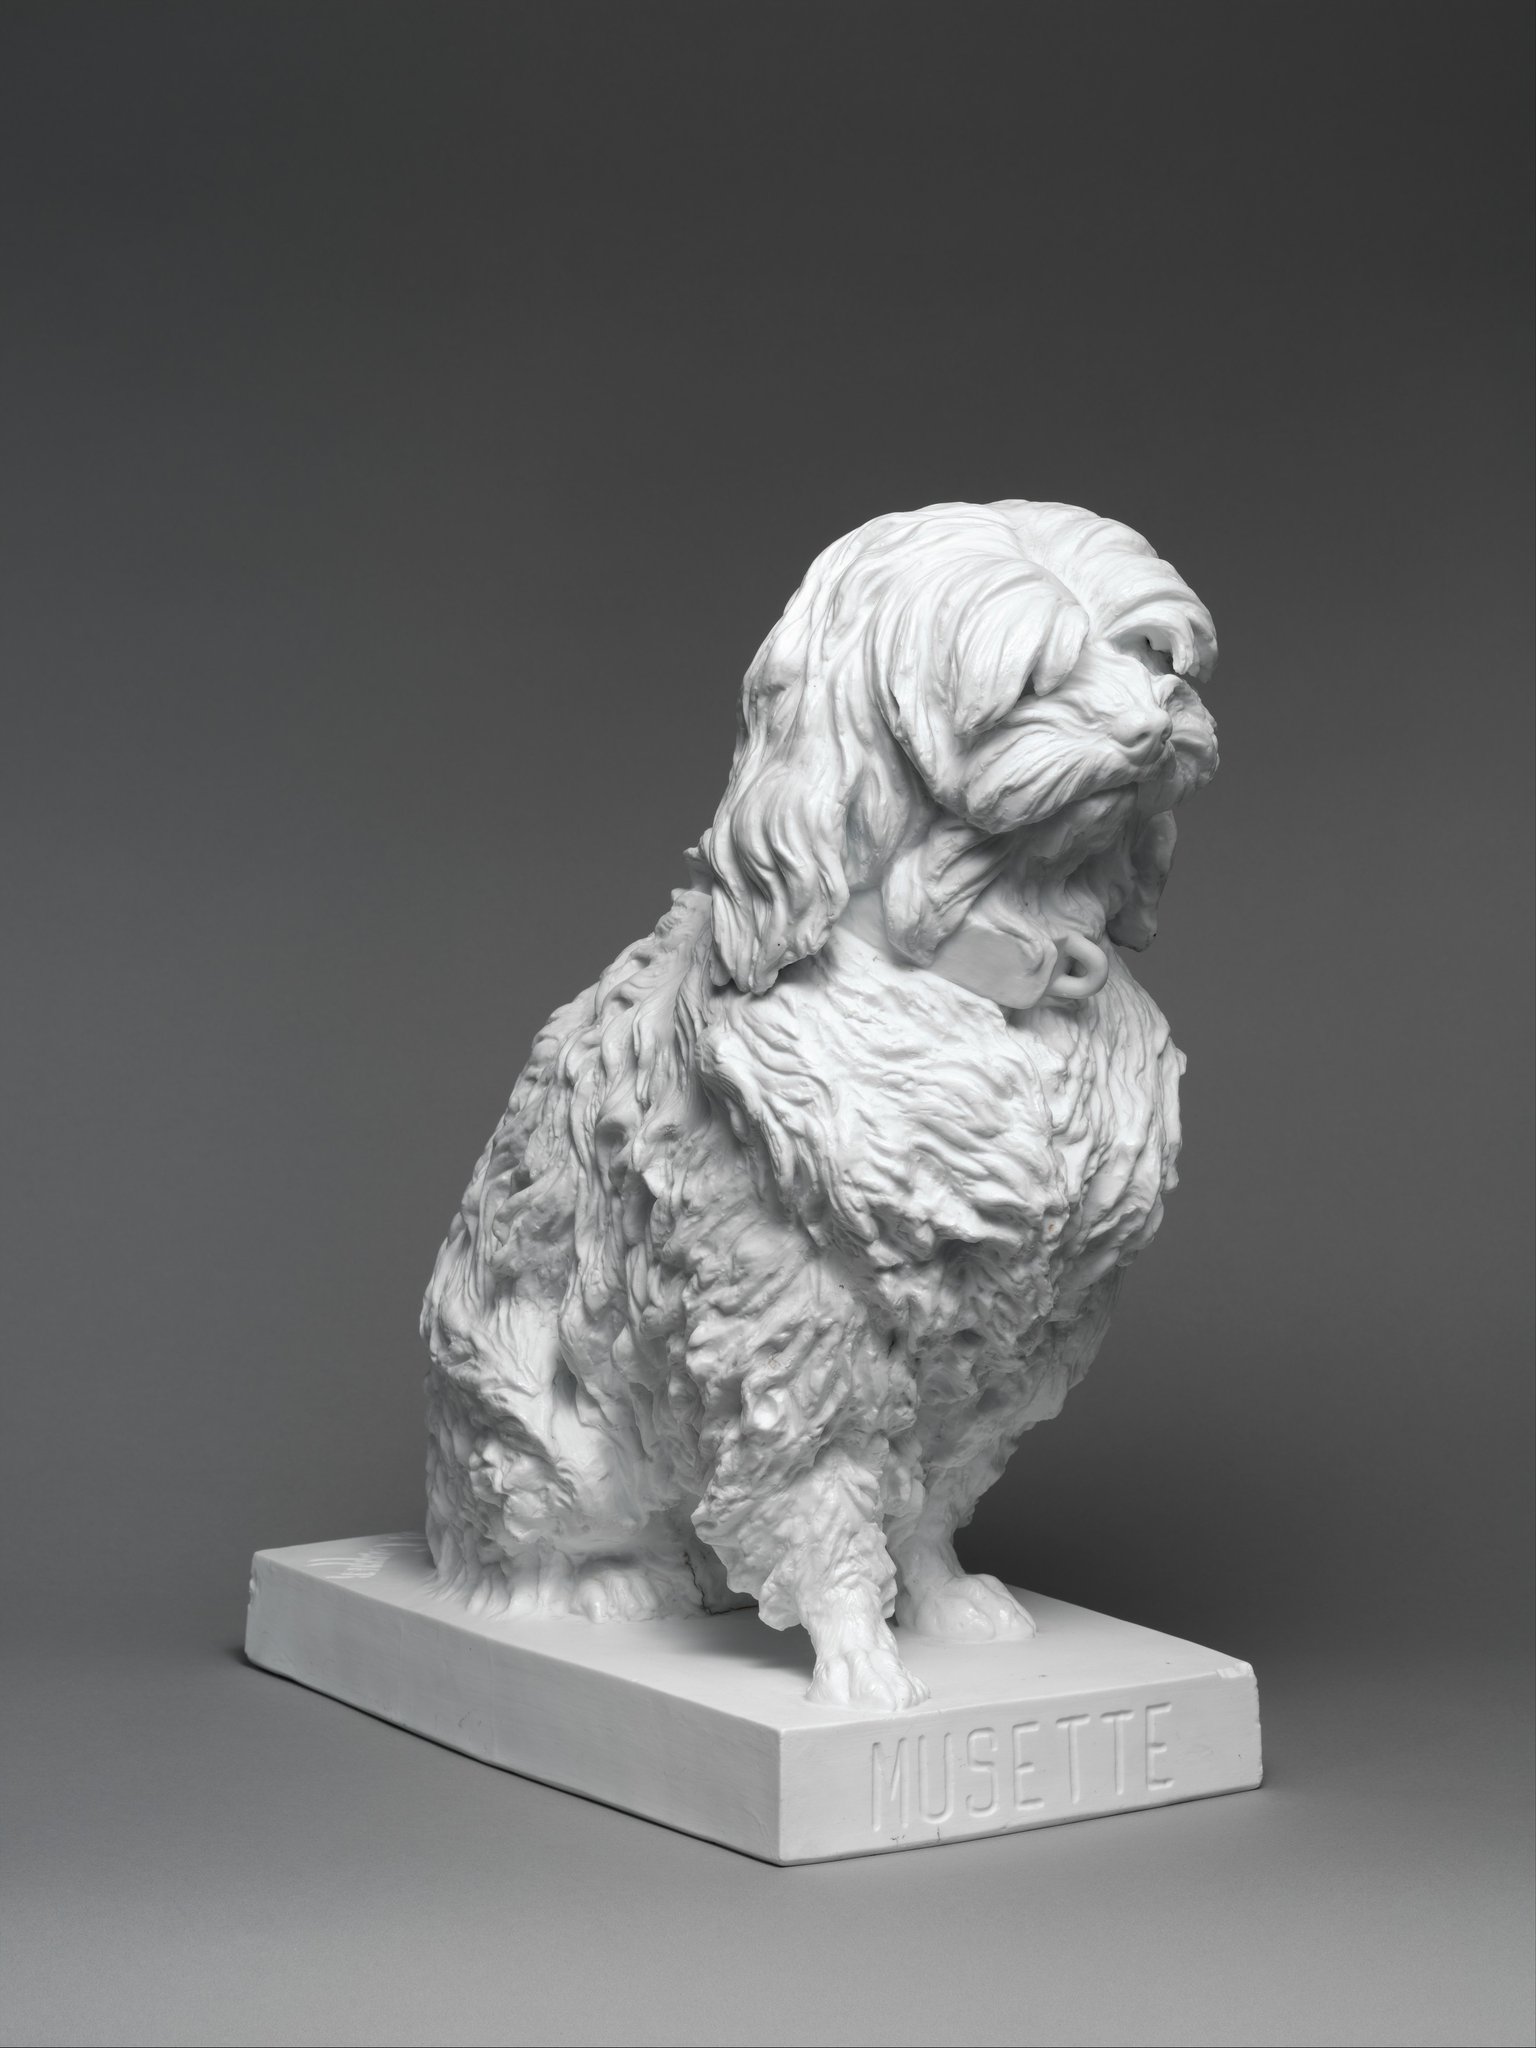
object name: figure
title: Musette, a Maltese dog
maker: jean-baptiste gille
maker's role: maker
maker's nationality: french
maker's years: 1798-1868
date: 1855-1868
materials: hard paste porcelain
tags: dogs